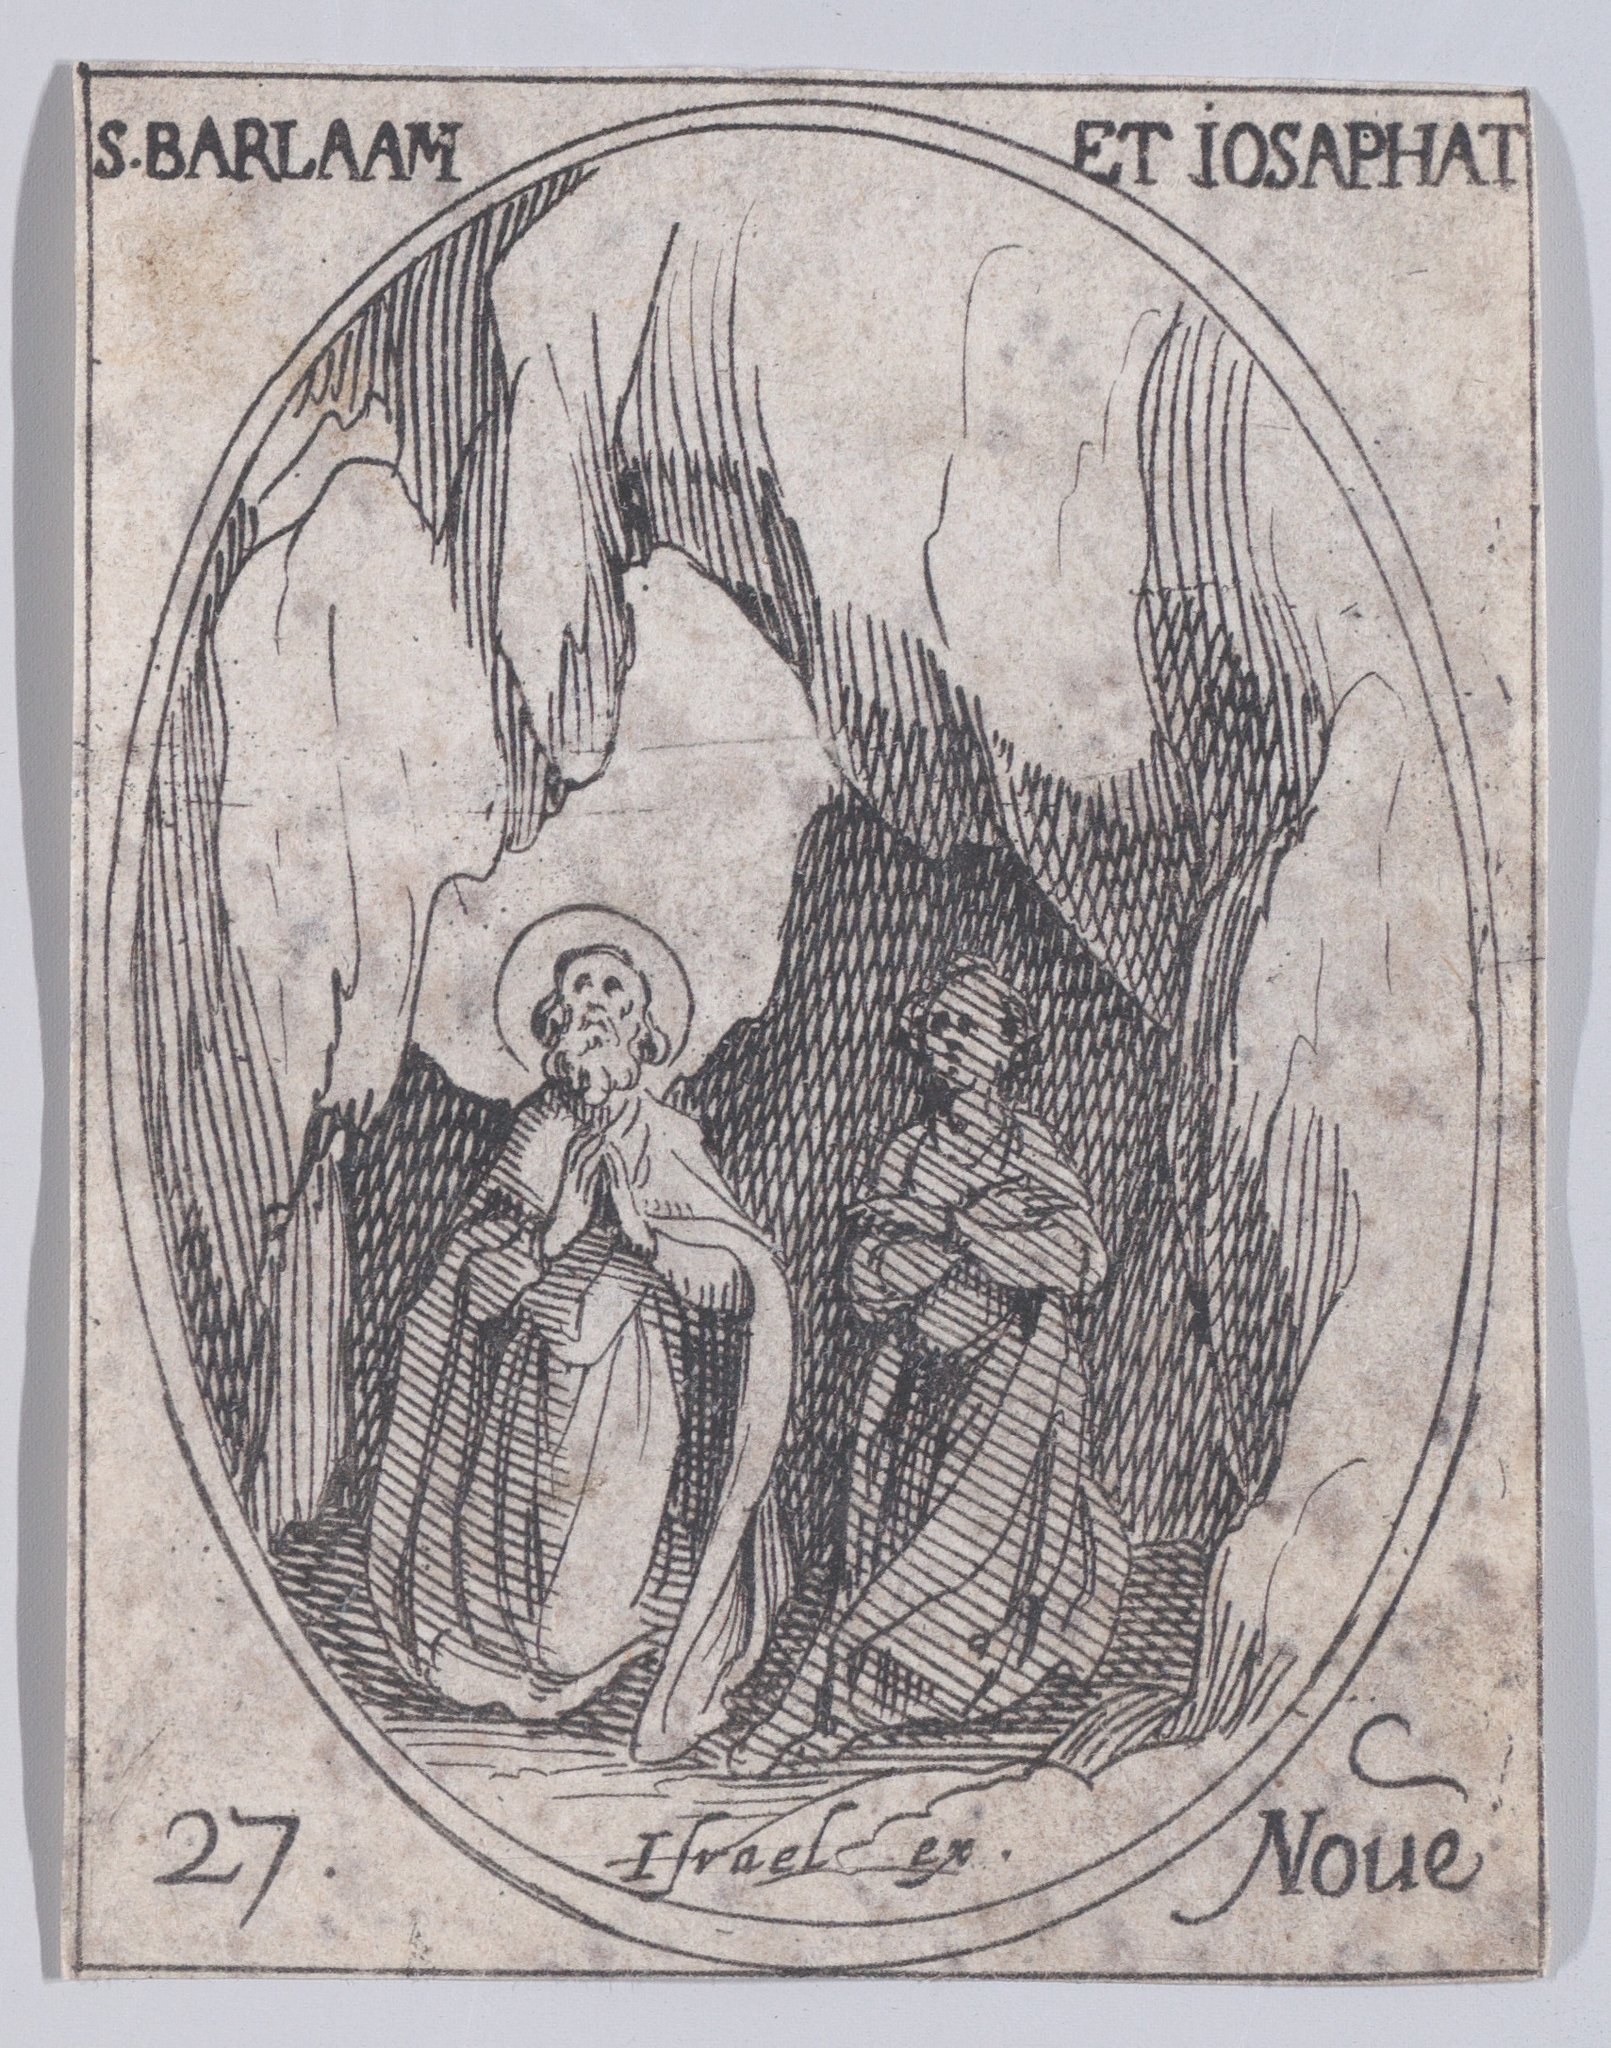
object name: print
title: St. Barlaam et St. Josaphat, November 27th, from "Les Images De Tous Les Saincts et Saintes de L'Année" (Images of All of the Saints and Religious Events of the Year)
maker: jacques callot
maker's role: artist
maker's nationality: french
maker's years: 1592-1635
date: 1636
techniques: etching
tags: men,saints